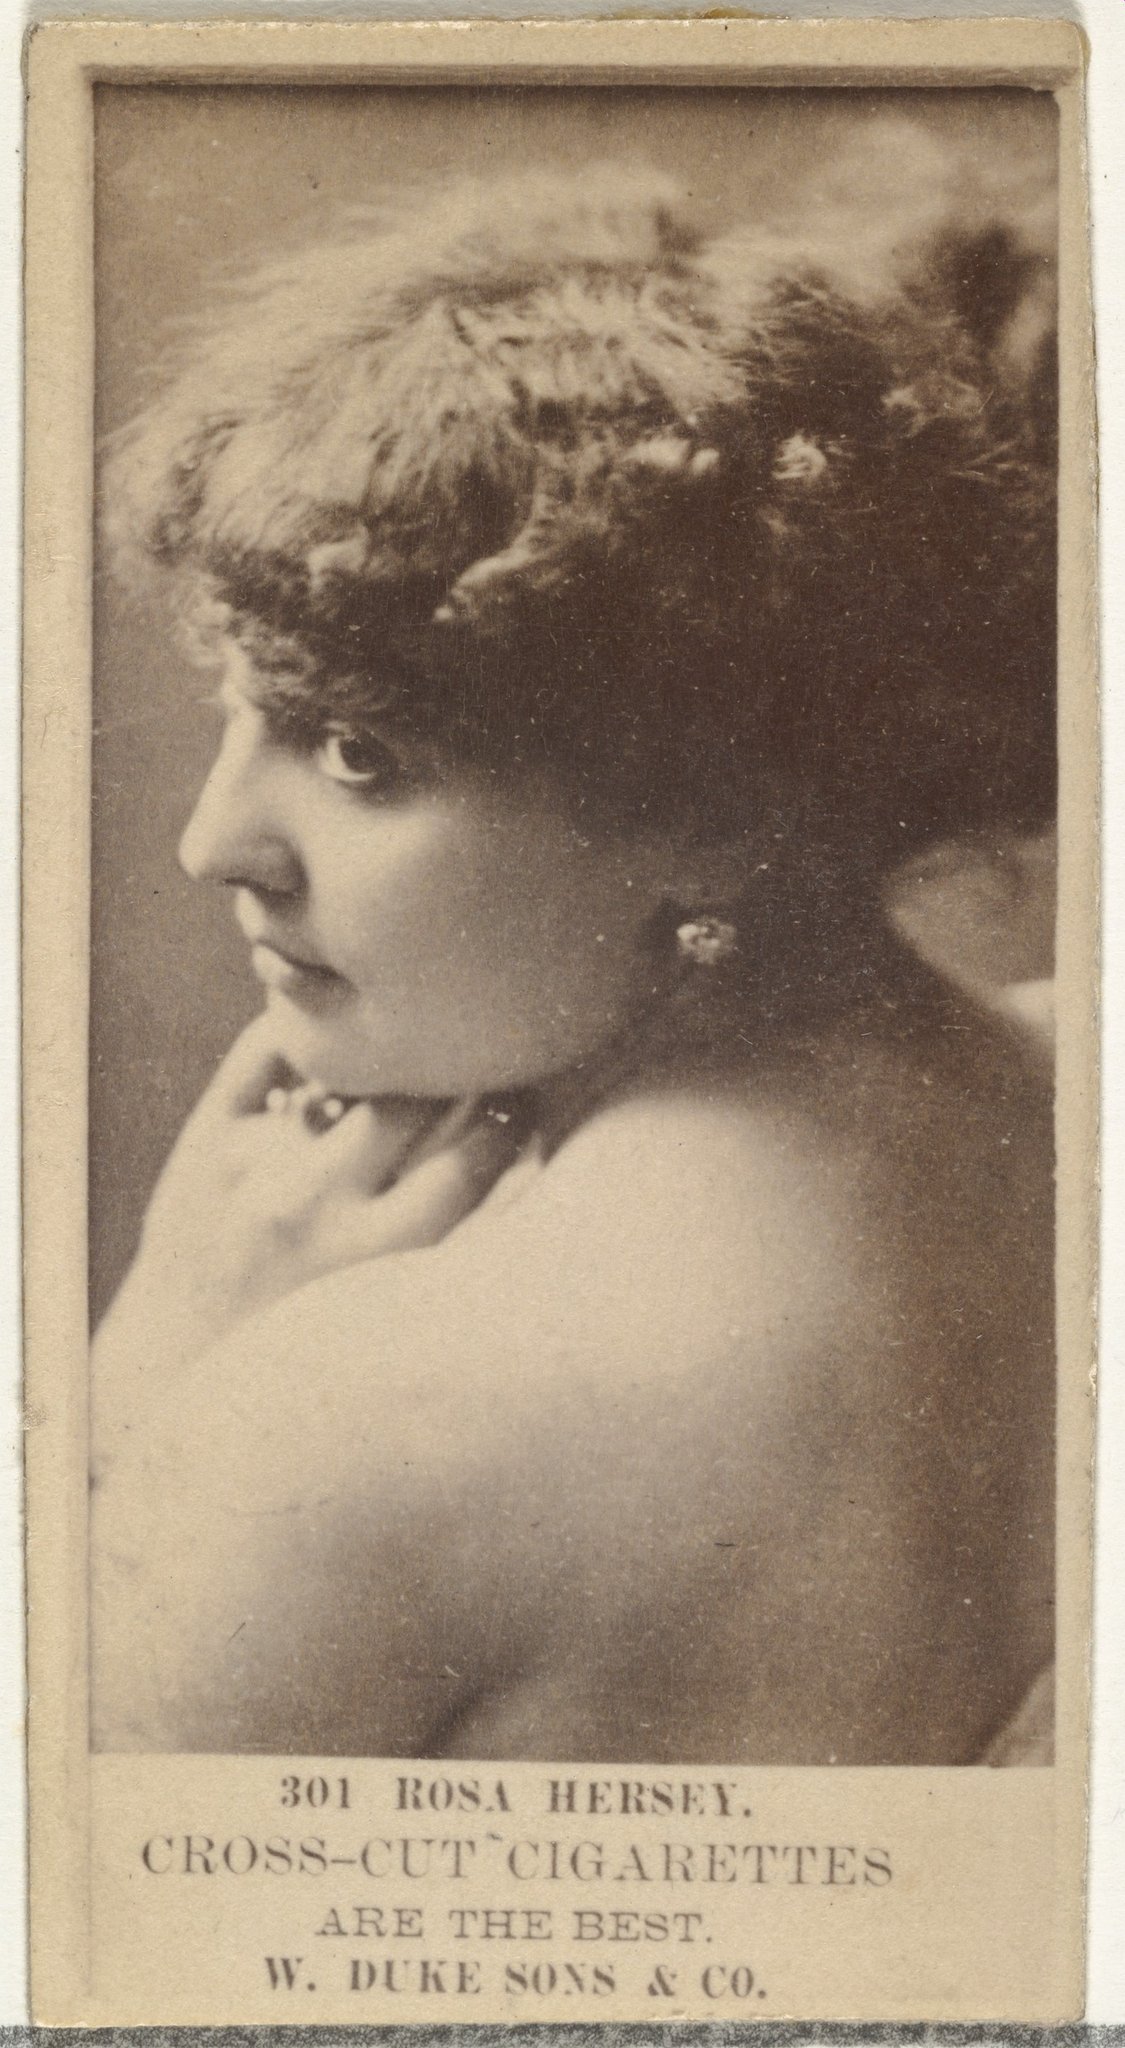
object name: photograph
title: Card Number 301, Rosa Hersey, from the Actors and Actresses series (N145-3) issued by Duke Sons & Co. to promote Cross Cut Cigarettes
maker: w. duke, sons & co.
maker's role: publisher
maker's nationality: american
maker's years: 1870-1920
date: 1880-1889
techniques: albumen silver print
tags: women,actresses